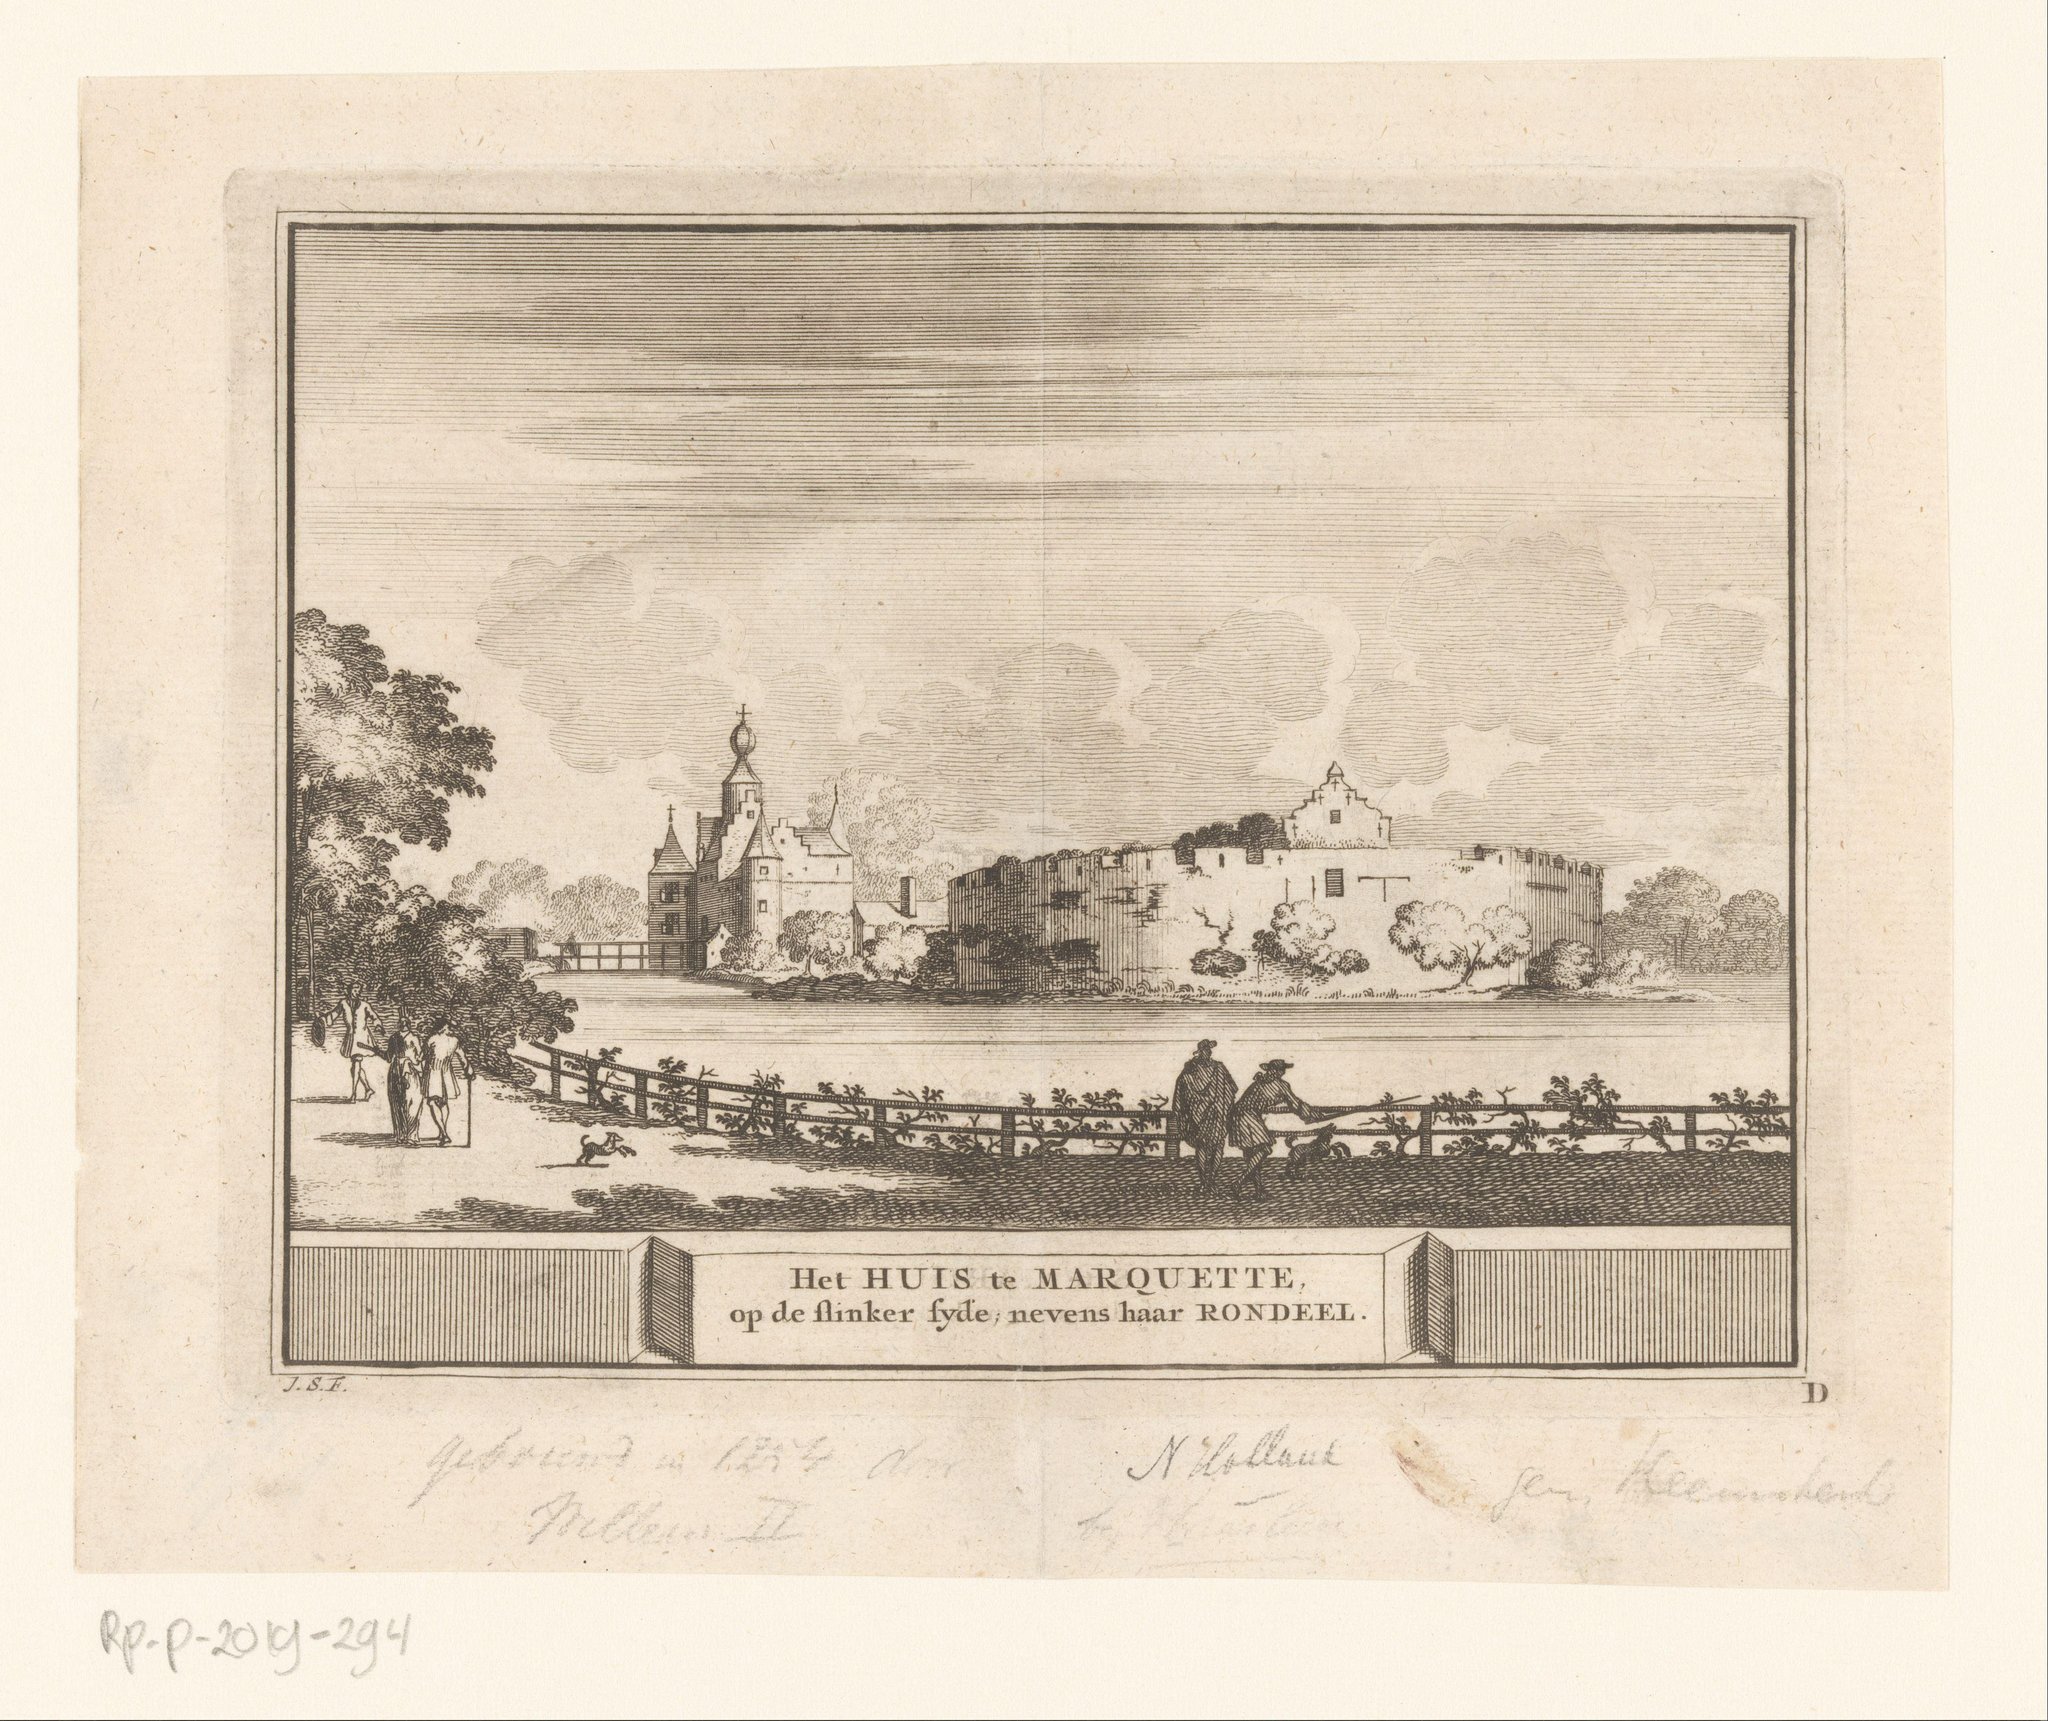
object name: book illustration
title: Het Huis te Marquette op de slinker zyde; nevens haar rondeel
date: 1711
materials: paper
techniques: etching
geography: amsterdam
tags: castle, landscape with tower or castle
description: Prent voor het eerst gebruikt in: Smids, Ludolph. Schatkamer der Nederlandsse oudheden; of Woordenboek, behelsende Nederlands steden. Amsterdam: Pieter de Coup, 1711. Verscheen daarna in heruitgaven van dit werk in 1737 en 1774. In 1721 verscheen er een uitgave met alleen de prenten: Nederlandsche oudheden, bestaande in zestig verbeeldingen (...) gelegen in Holland, 't Sticht van Utrecht en Gelderland enz. Amsterdam: Hendrik Bosch, 1721.